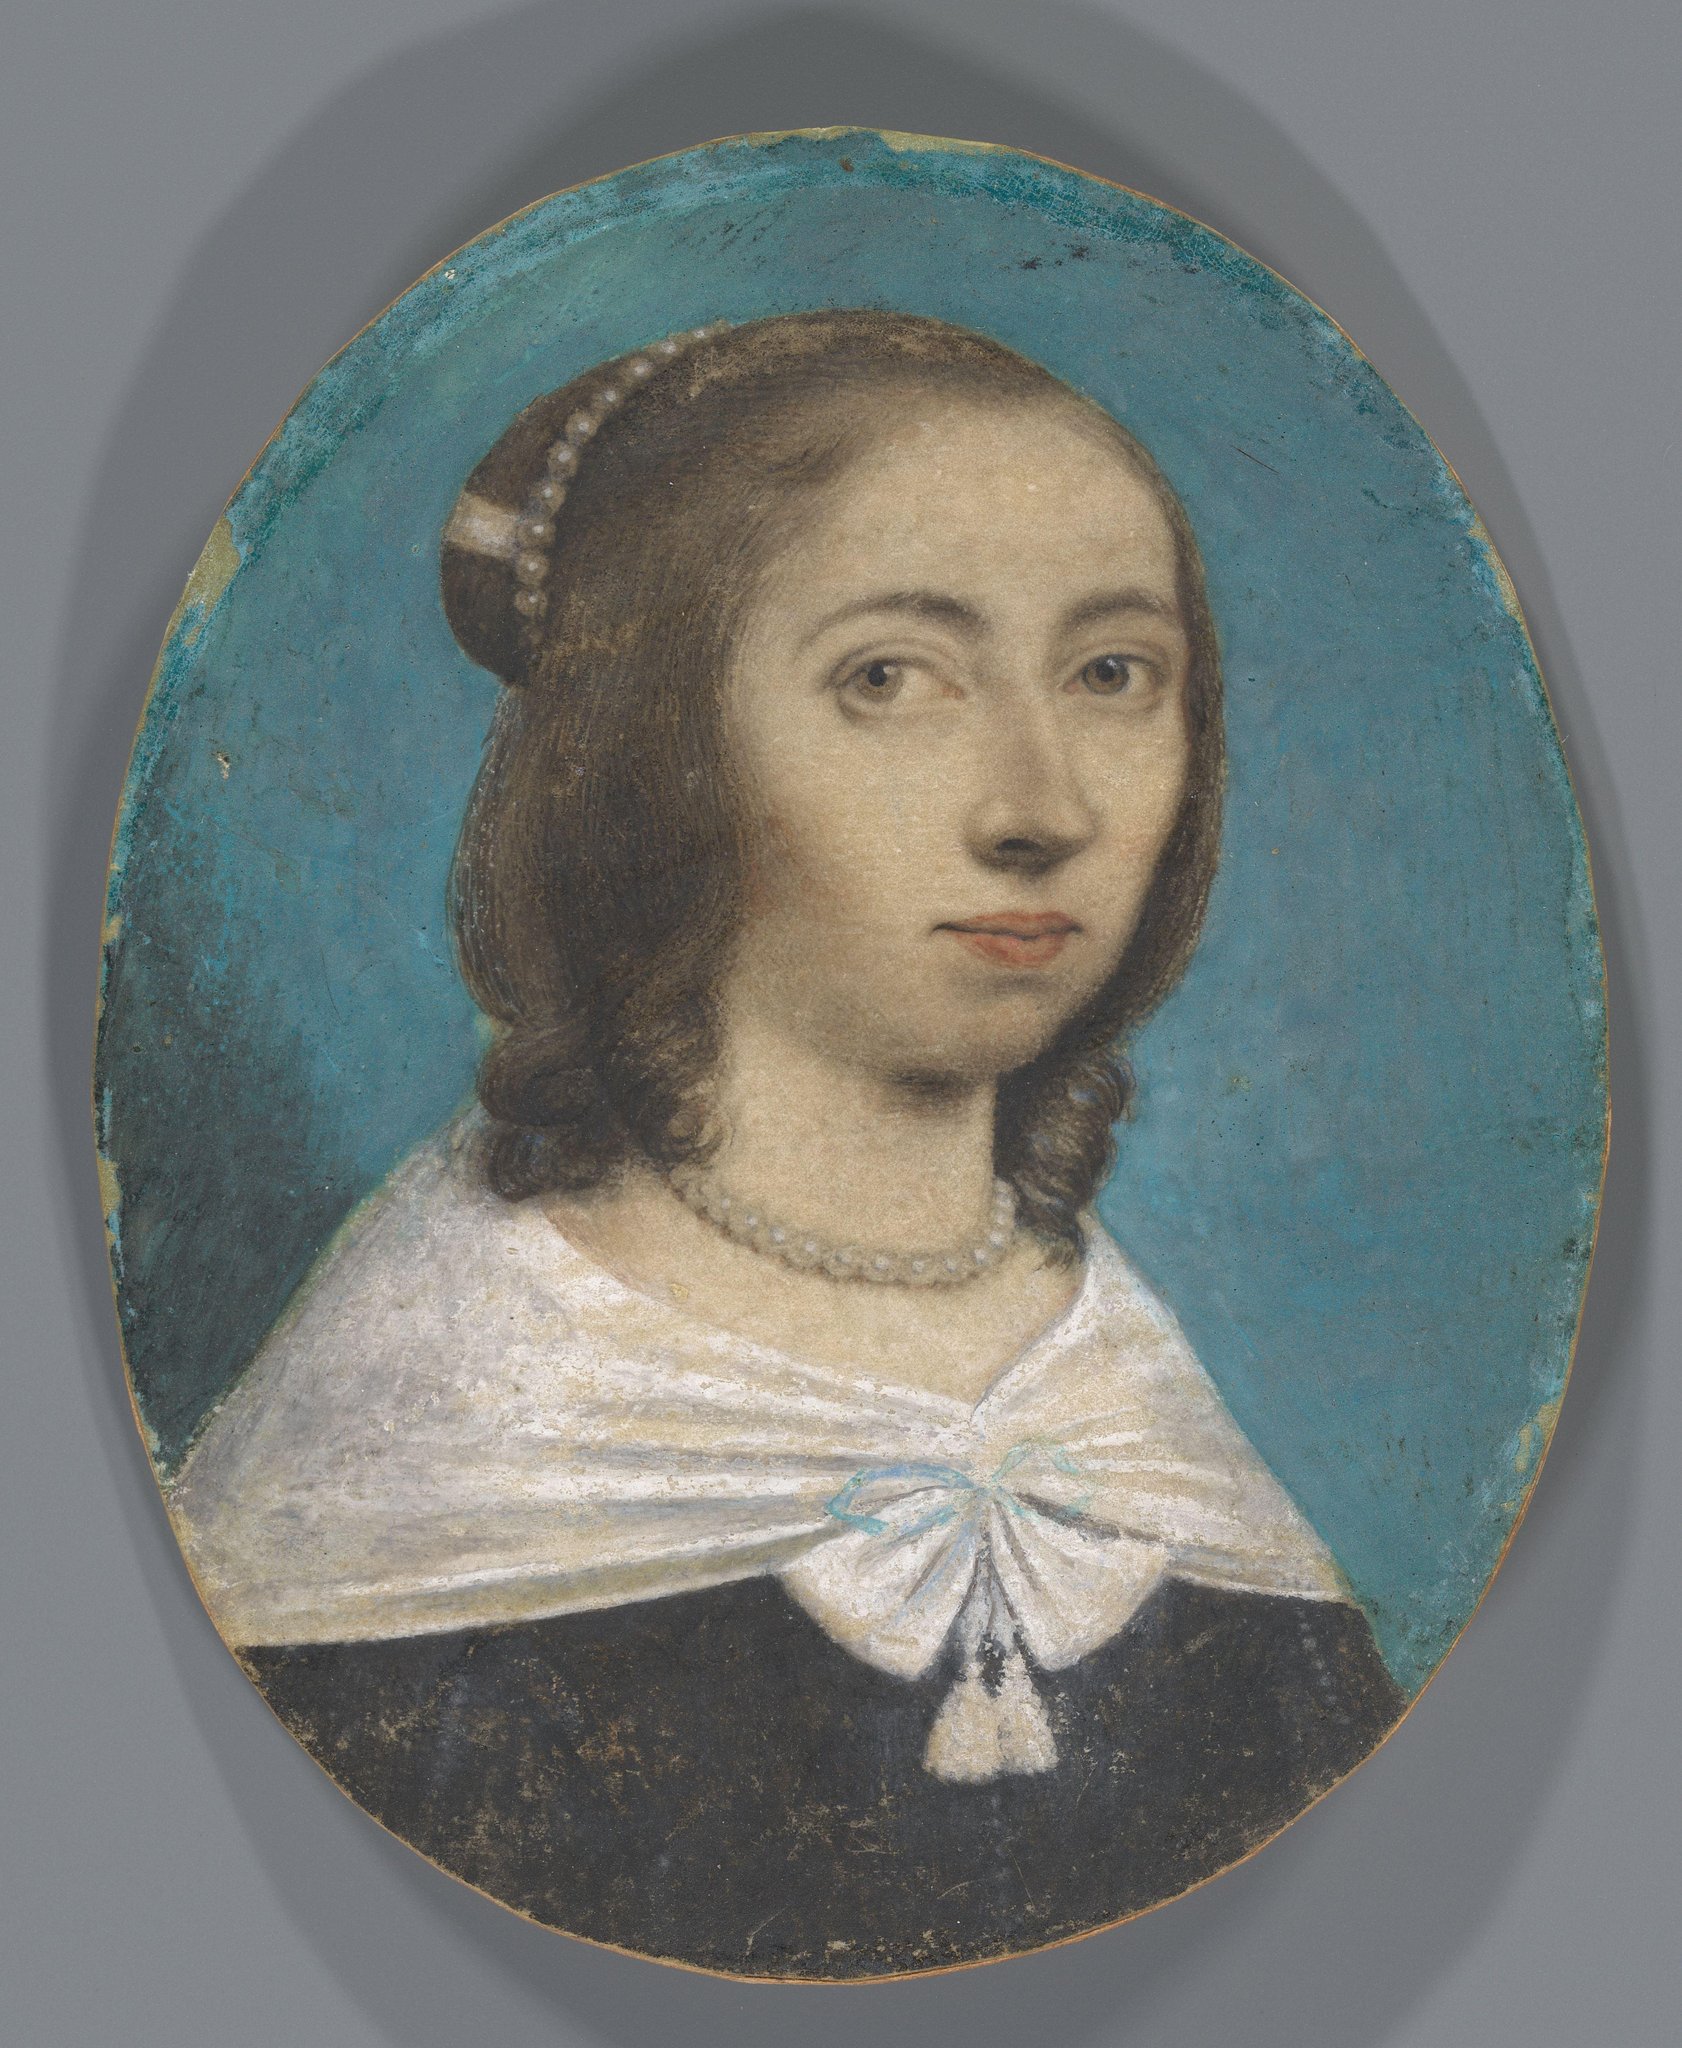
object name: painting, miniature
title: Portret van een vrouw, mogelijk Anna Maria van Schurman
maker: anna maria van schurman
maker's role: draughtsman, print maker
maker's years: 1607-1678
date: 1652-1725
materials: cardboard, gouache, graphite, parchment, pastel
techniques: brush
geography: northern netherlands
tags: cologne, print maker, anna maria van schurman, historical persons - bb - woman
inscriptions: inscription: ‘Anna Maria / Schurman / hanc suam effigiem / ipsa pinxit / actatis suac / anno 44 / 1652’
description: Portret van een vrouw, mogelijk Anna Maria van Schurman. De geportretteerde vrouw is driekwart naar rechts gedraaid en draagt een zwarte jurk die vooraan en op de mouwen van een siermotiefje is voorzien. Over de schouders is een witte kegelvormige kraag gelegd die vooraan wordt bijeengehouden door een vlinderstrik waaraan twee akertjes zijn bevestigd. Daarop ligt een blauwe strik (momenteel slecht zichtbaar). Haar kapsel bestaat uit een wrong op het achterhoofd en losse haren eindigend in krullen die neerhangen tot op de schouders. In het dotje draagt ze een breed lint en een parelsnoer dat correspondeert met het rond de hals gedragen juweel. De achtergrond waartegen ze is afgebeeld is op een donkere slagschaduw achter de geportretteerde na, vlak en licht gehouden.